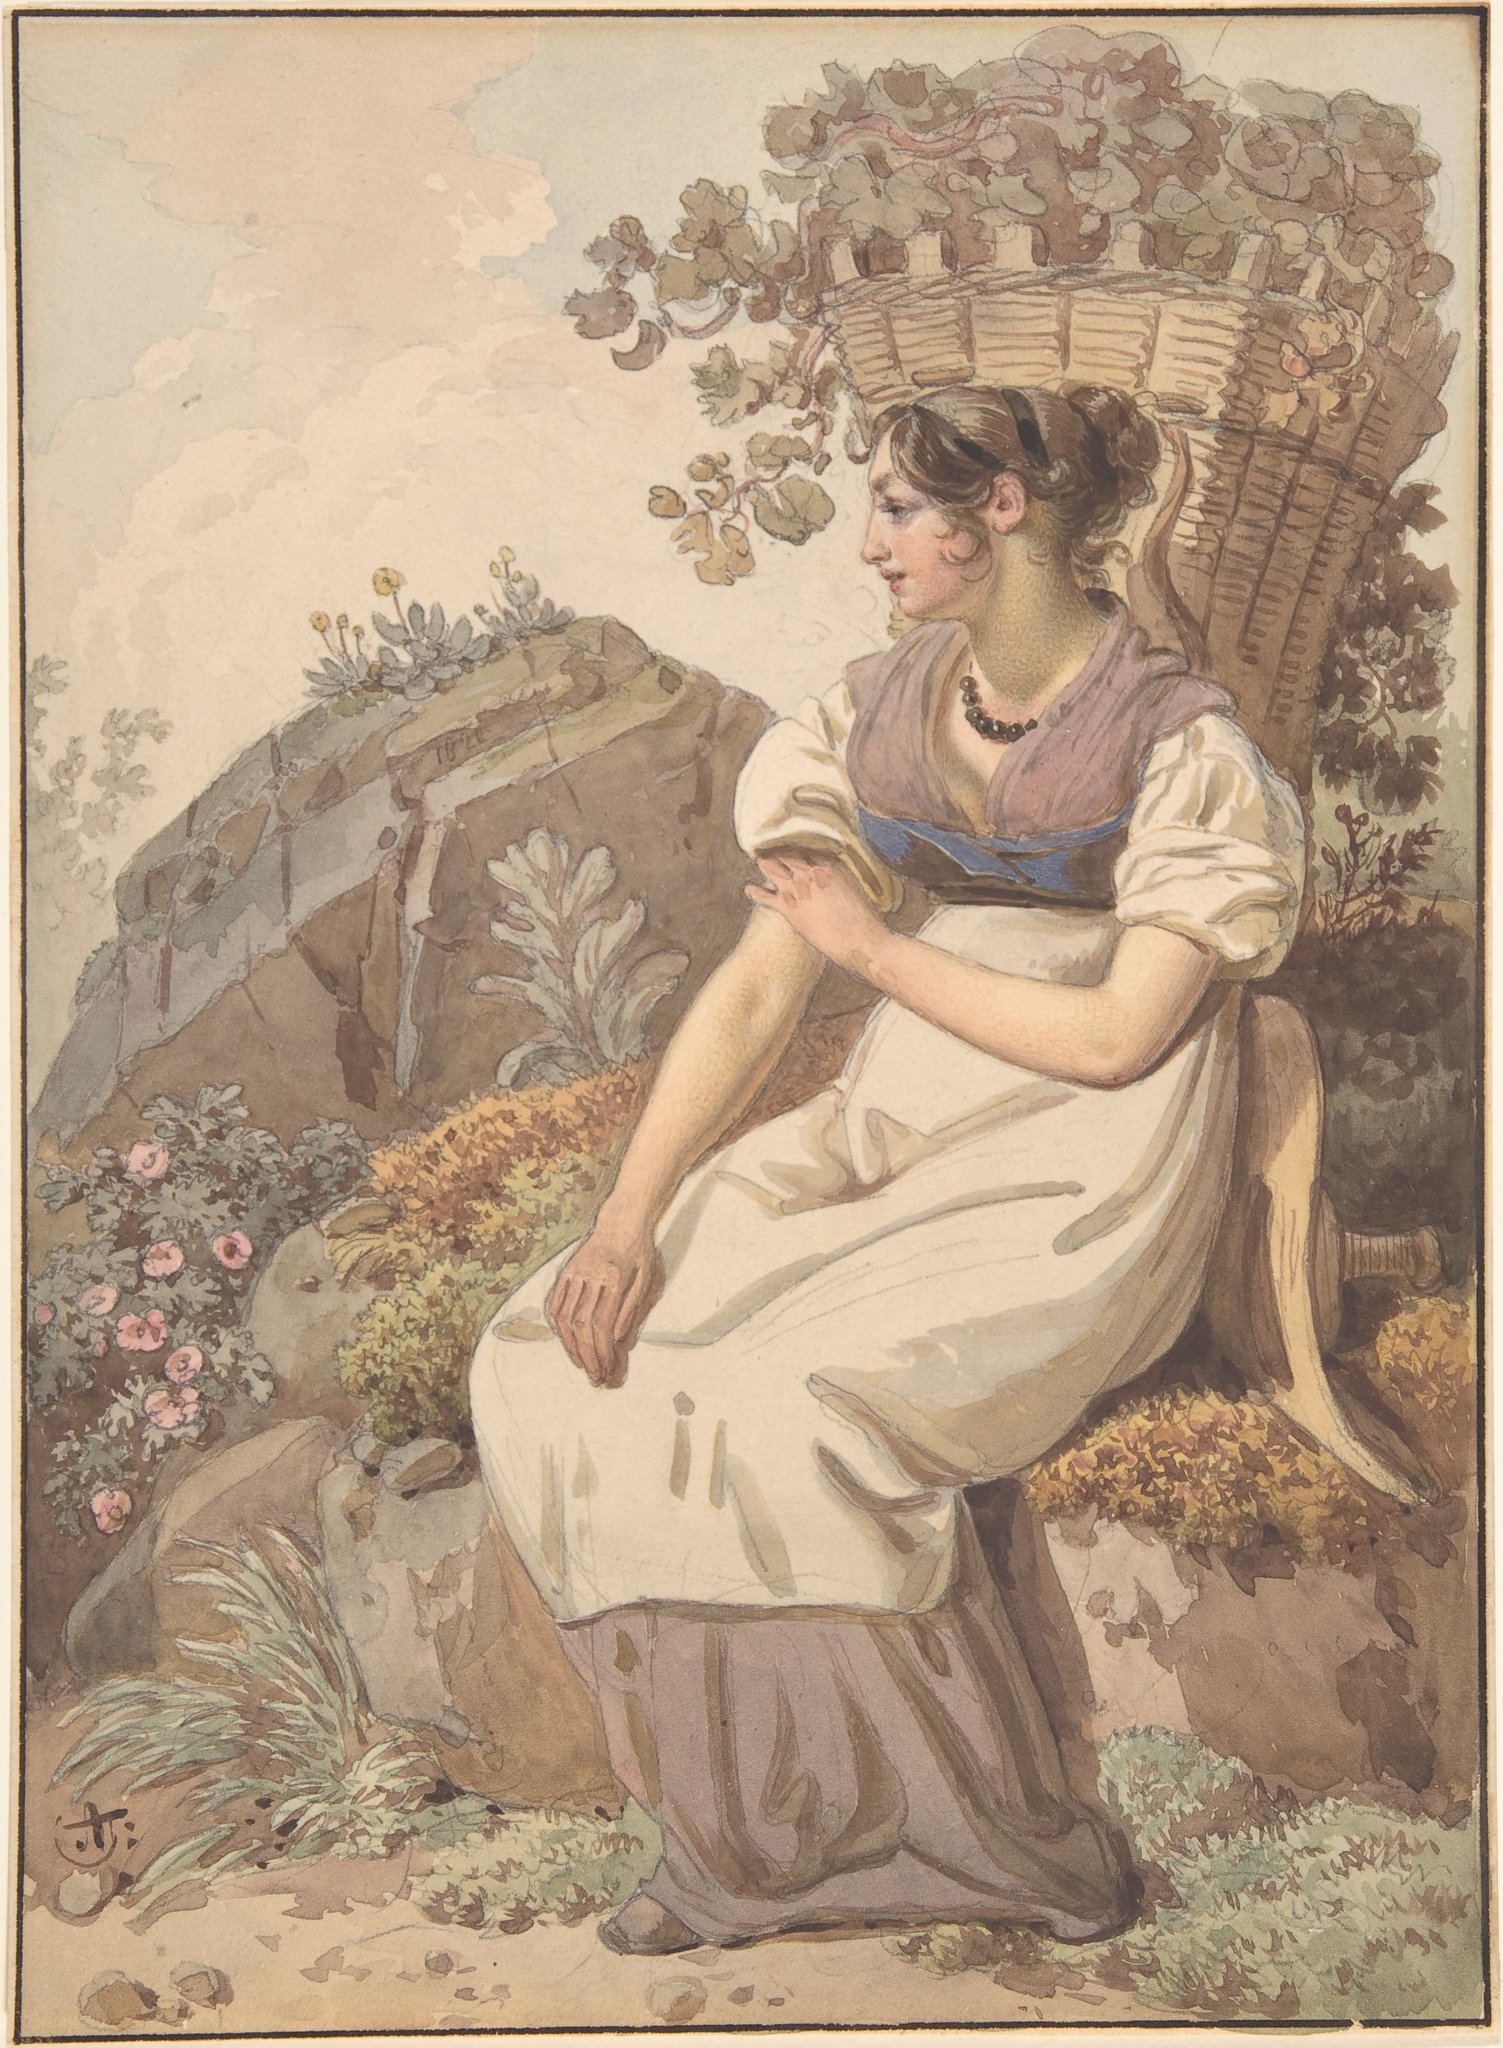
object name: drawing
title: Young Woman in the Vaudois after the Grape Harvest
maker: wolfgang adam töpffer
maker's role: artist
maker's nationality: swiss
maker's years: 1766-1847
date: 1821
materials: chalk, graphite, ink, watercolor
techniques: pen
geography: switzerland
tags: grapes,women,leaves